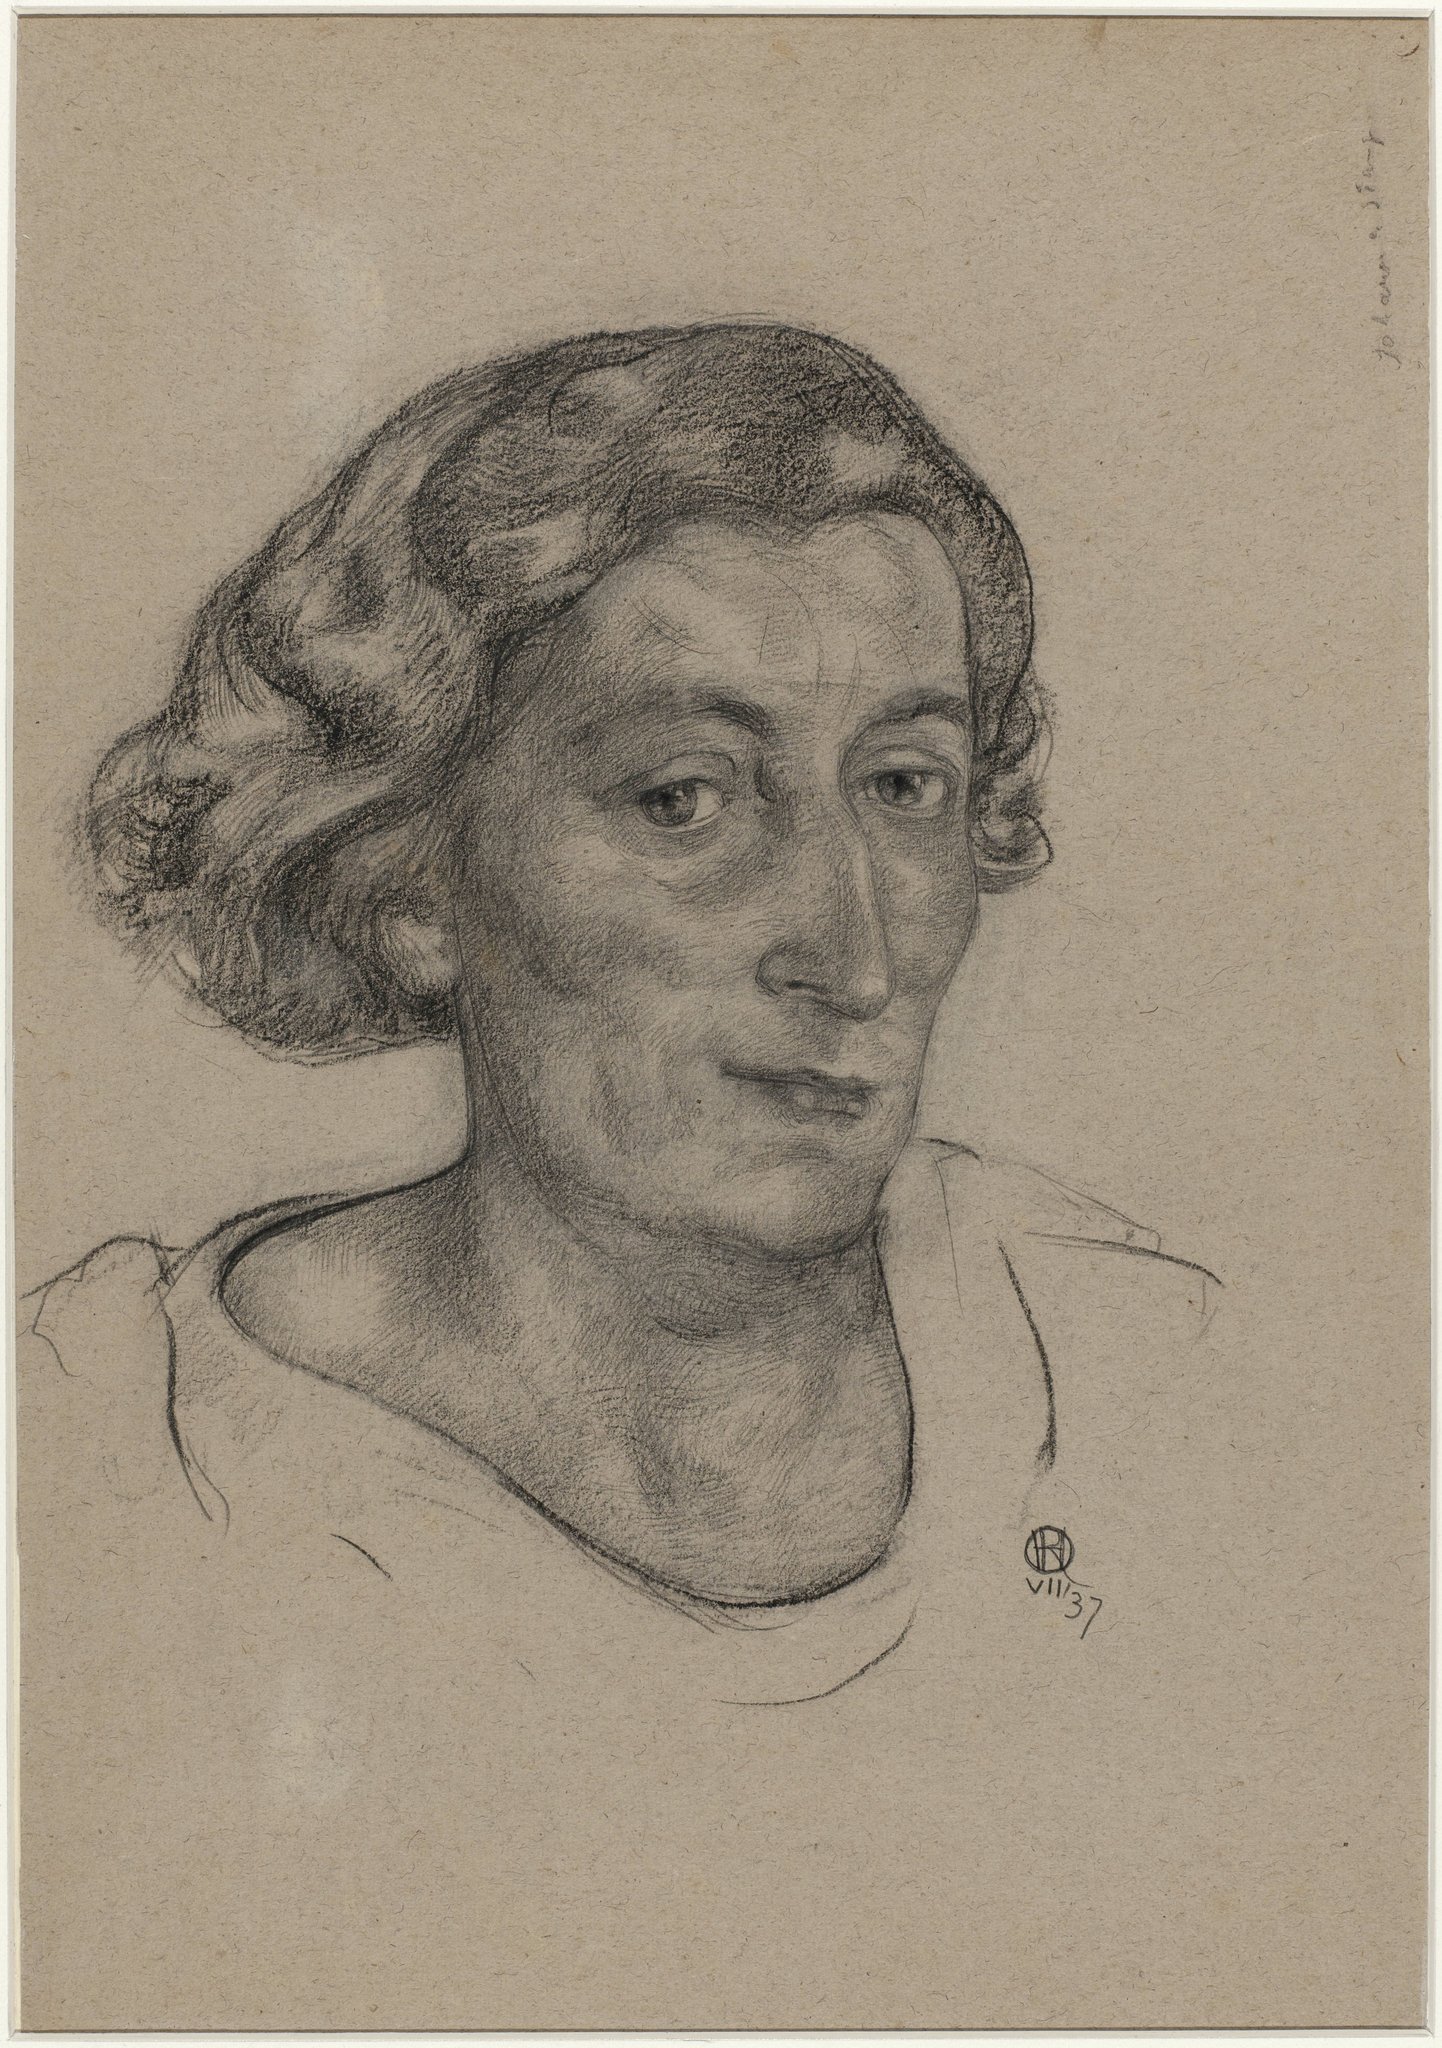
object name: drawing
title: Portret van Jo Bauer-Stumpff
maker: richard nicolaüs roland holst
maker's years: 1868-1938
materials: chalk, paper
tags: amsterdam, draughtsman, johanna bauer-stumpff, historical persons